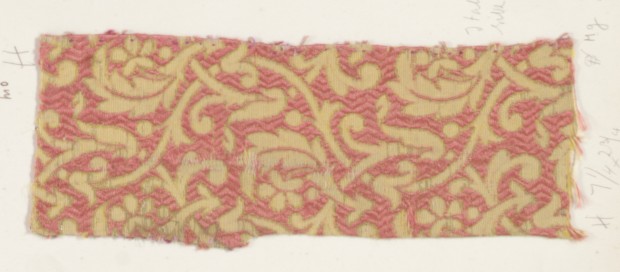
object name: fragment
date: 1601-1900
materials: metal thread, silk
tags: leaves